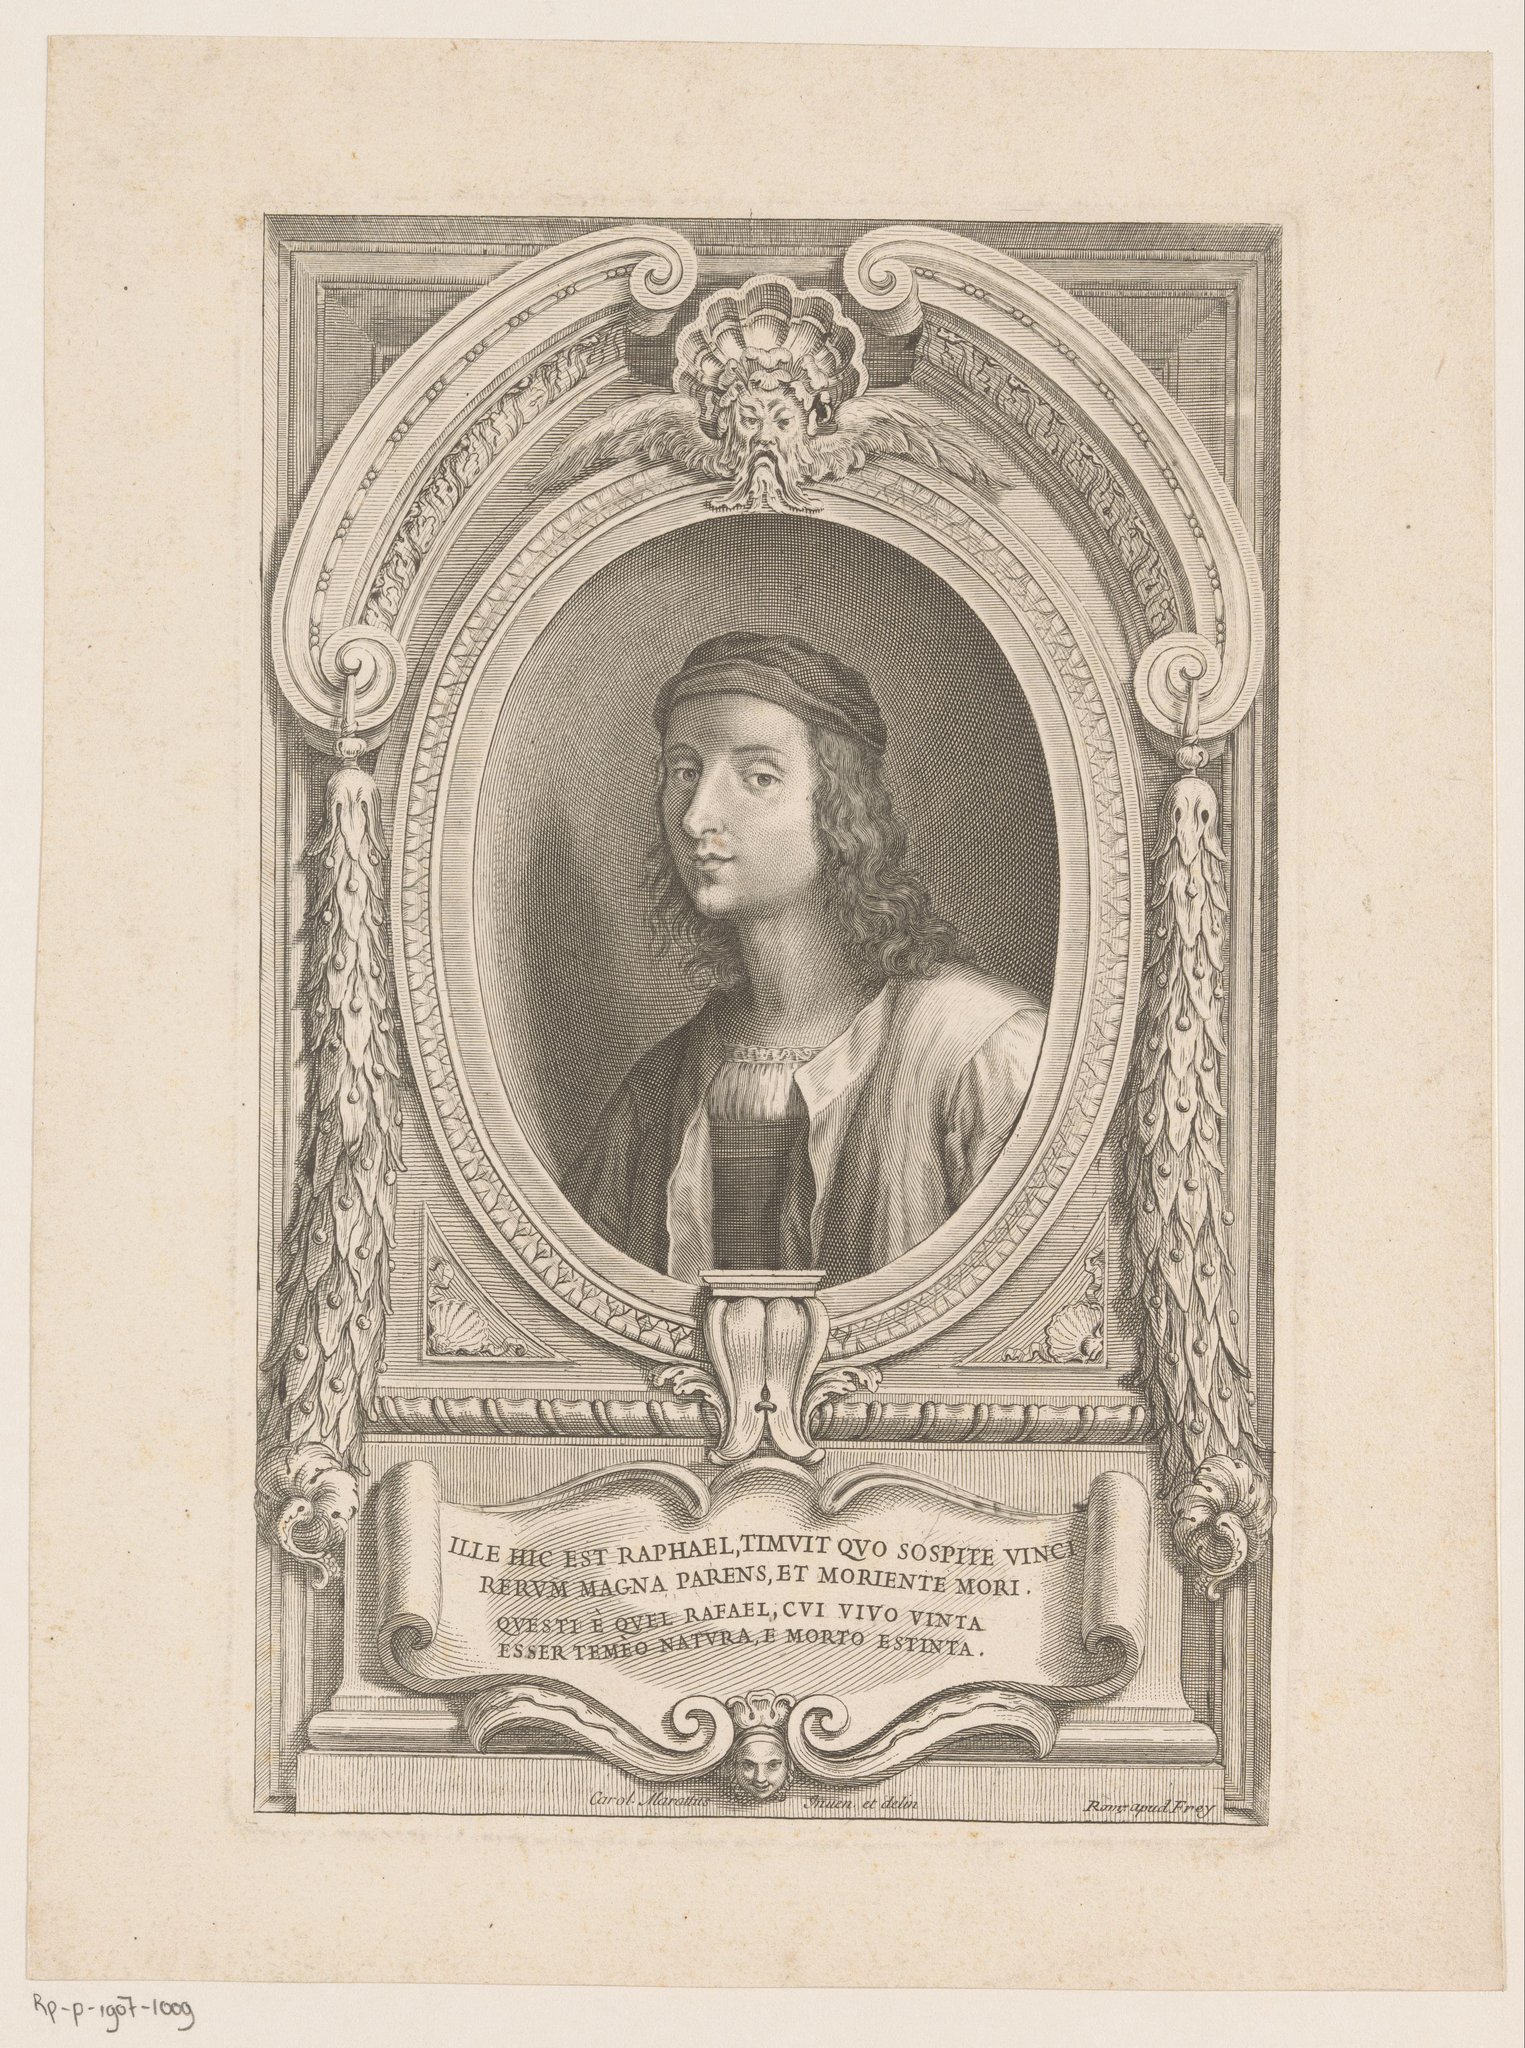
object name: print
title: Portret van Raphaël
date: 1691-1752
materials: paper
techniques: engraving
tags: rome, painter, rafaël, ornament ~ medallion, portrait, self-portrait of painter, ornament ~ cartouche, ornament derived from architectural details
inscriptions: collector's mark: Lugt 2228